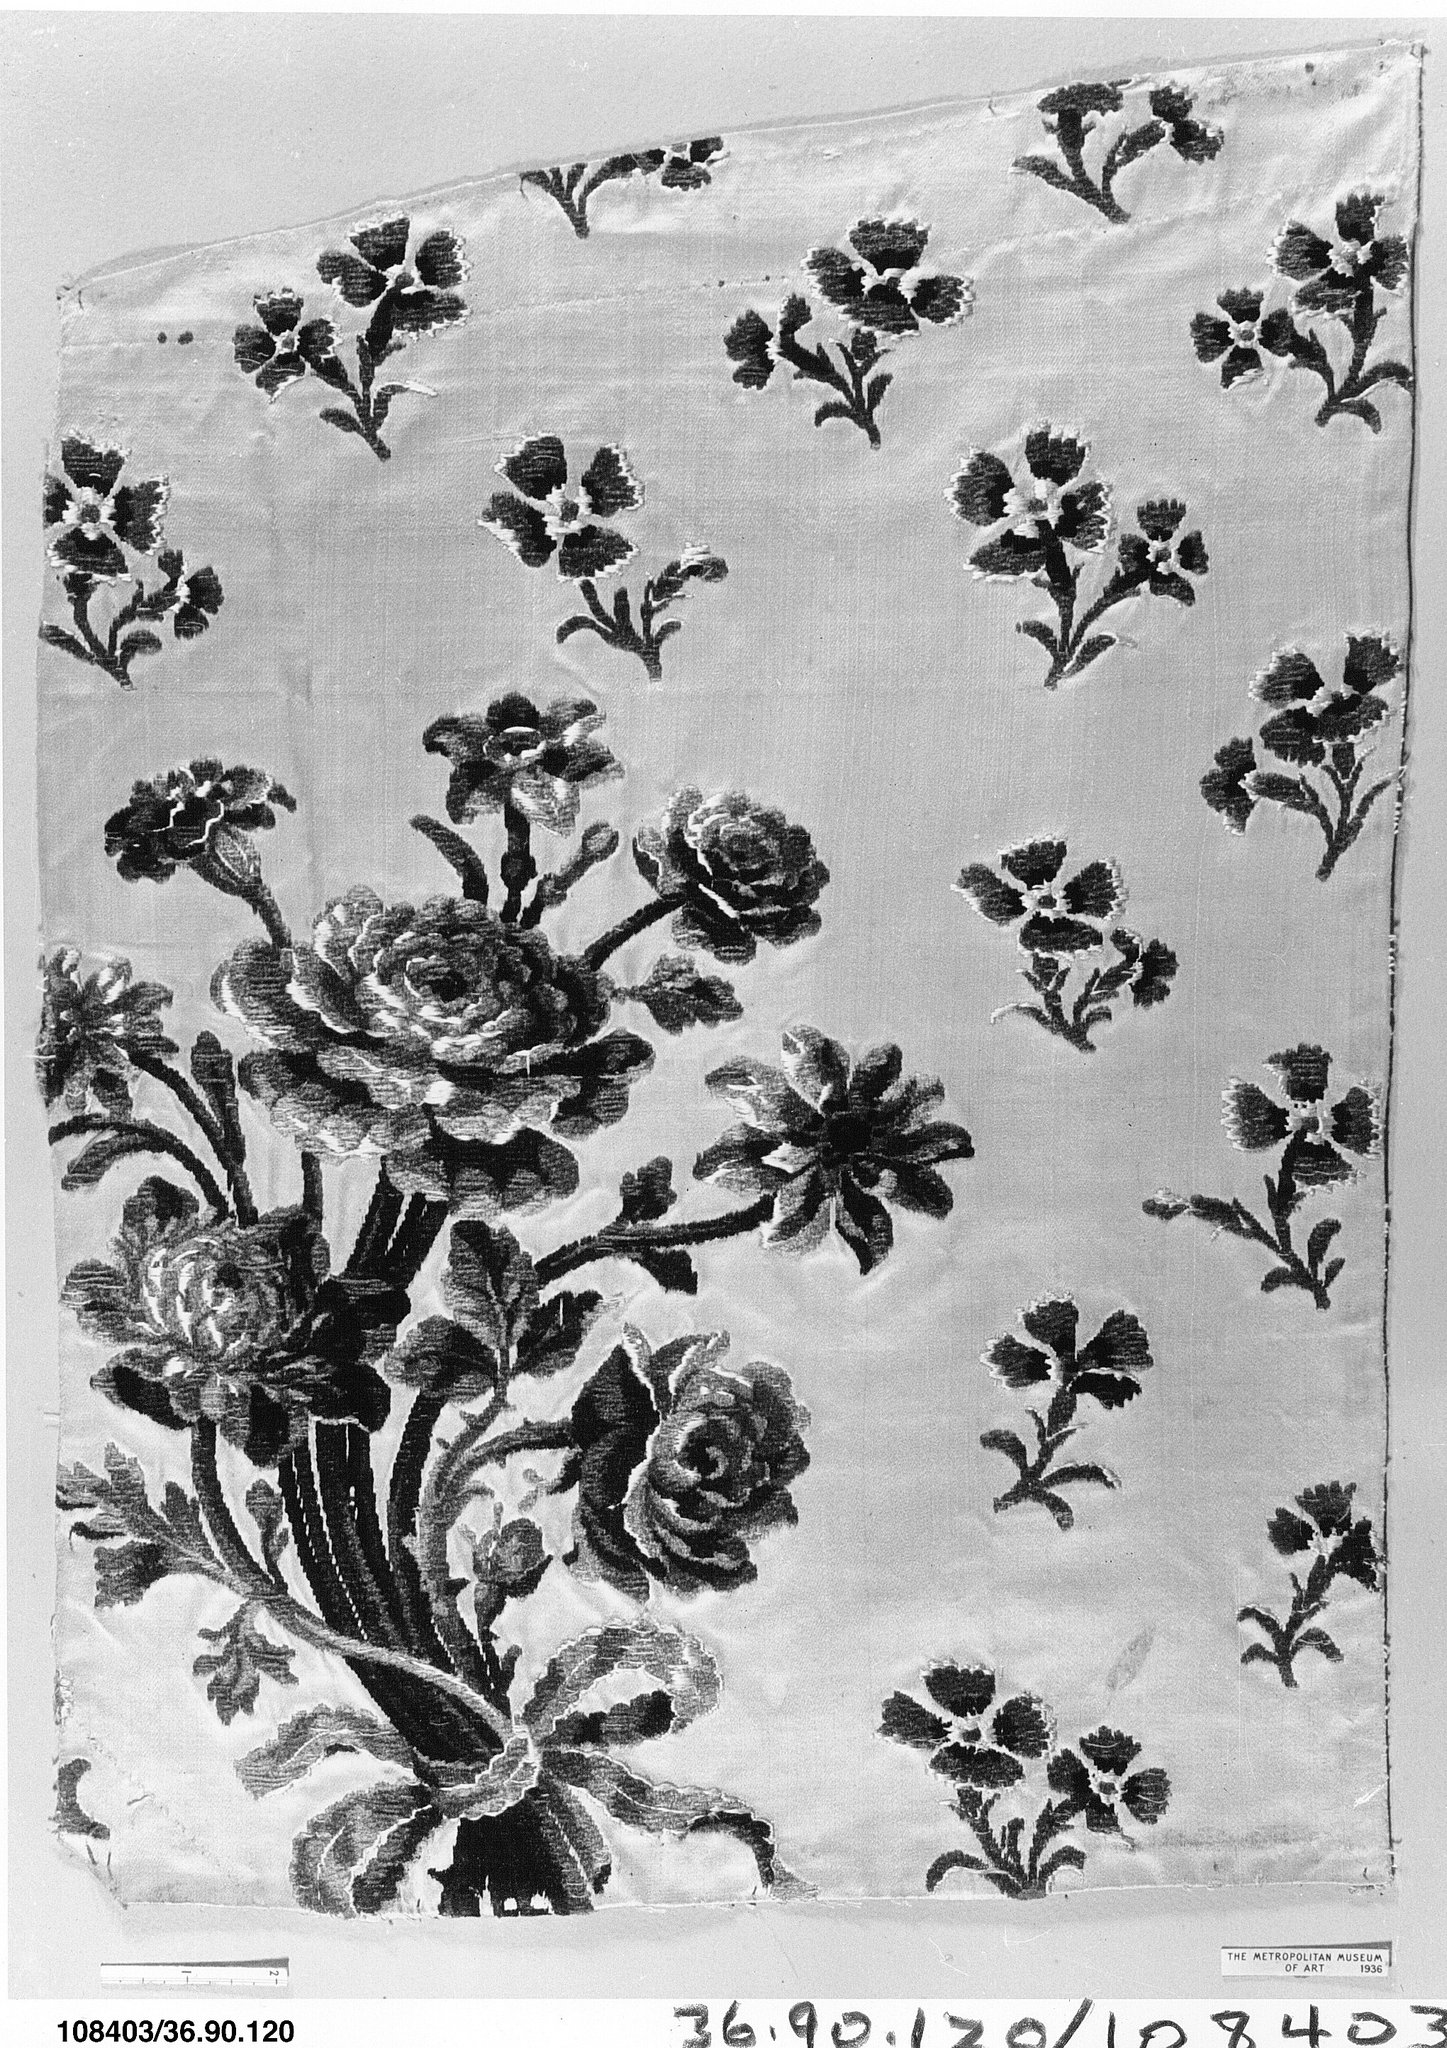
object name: piece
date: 1750-1760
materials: silk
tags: flowers